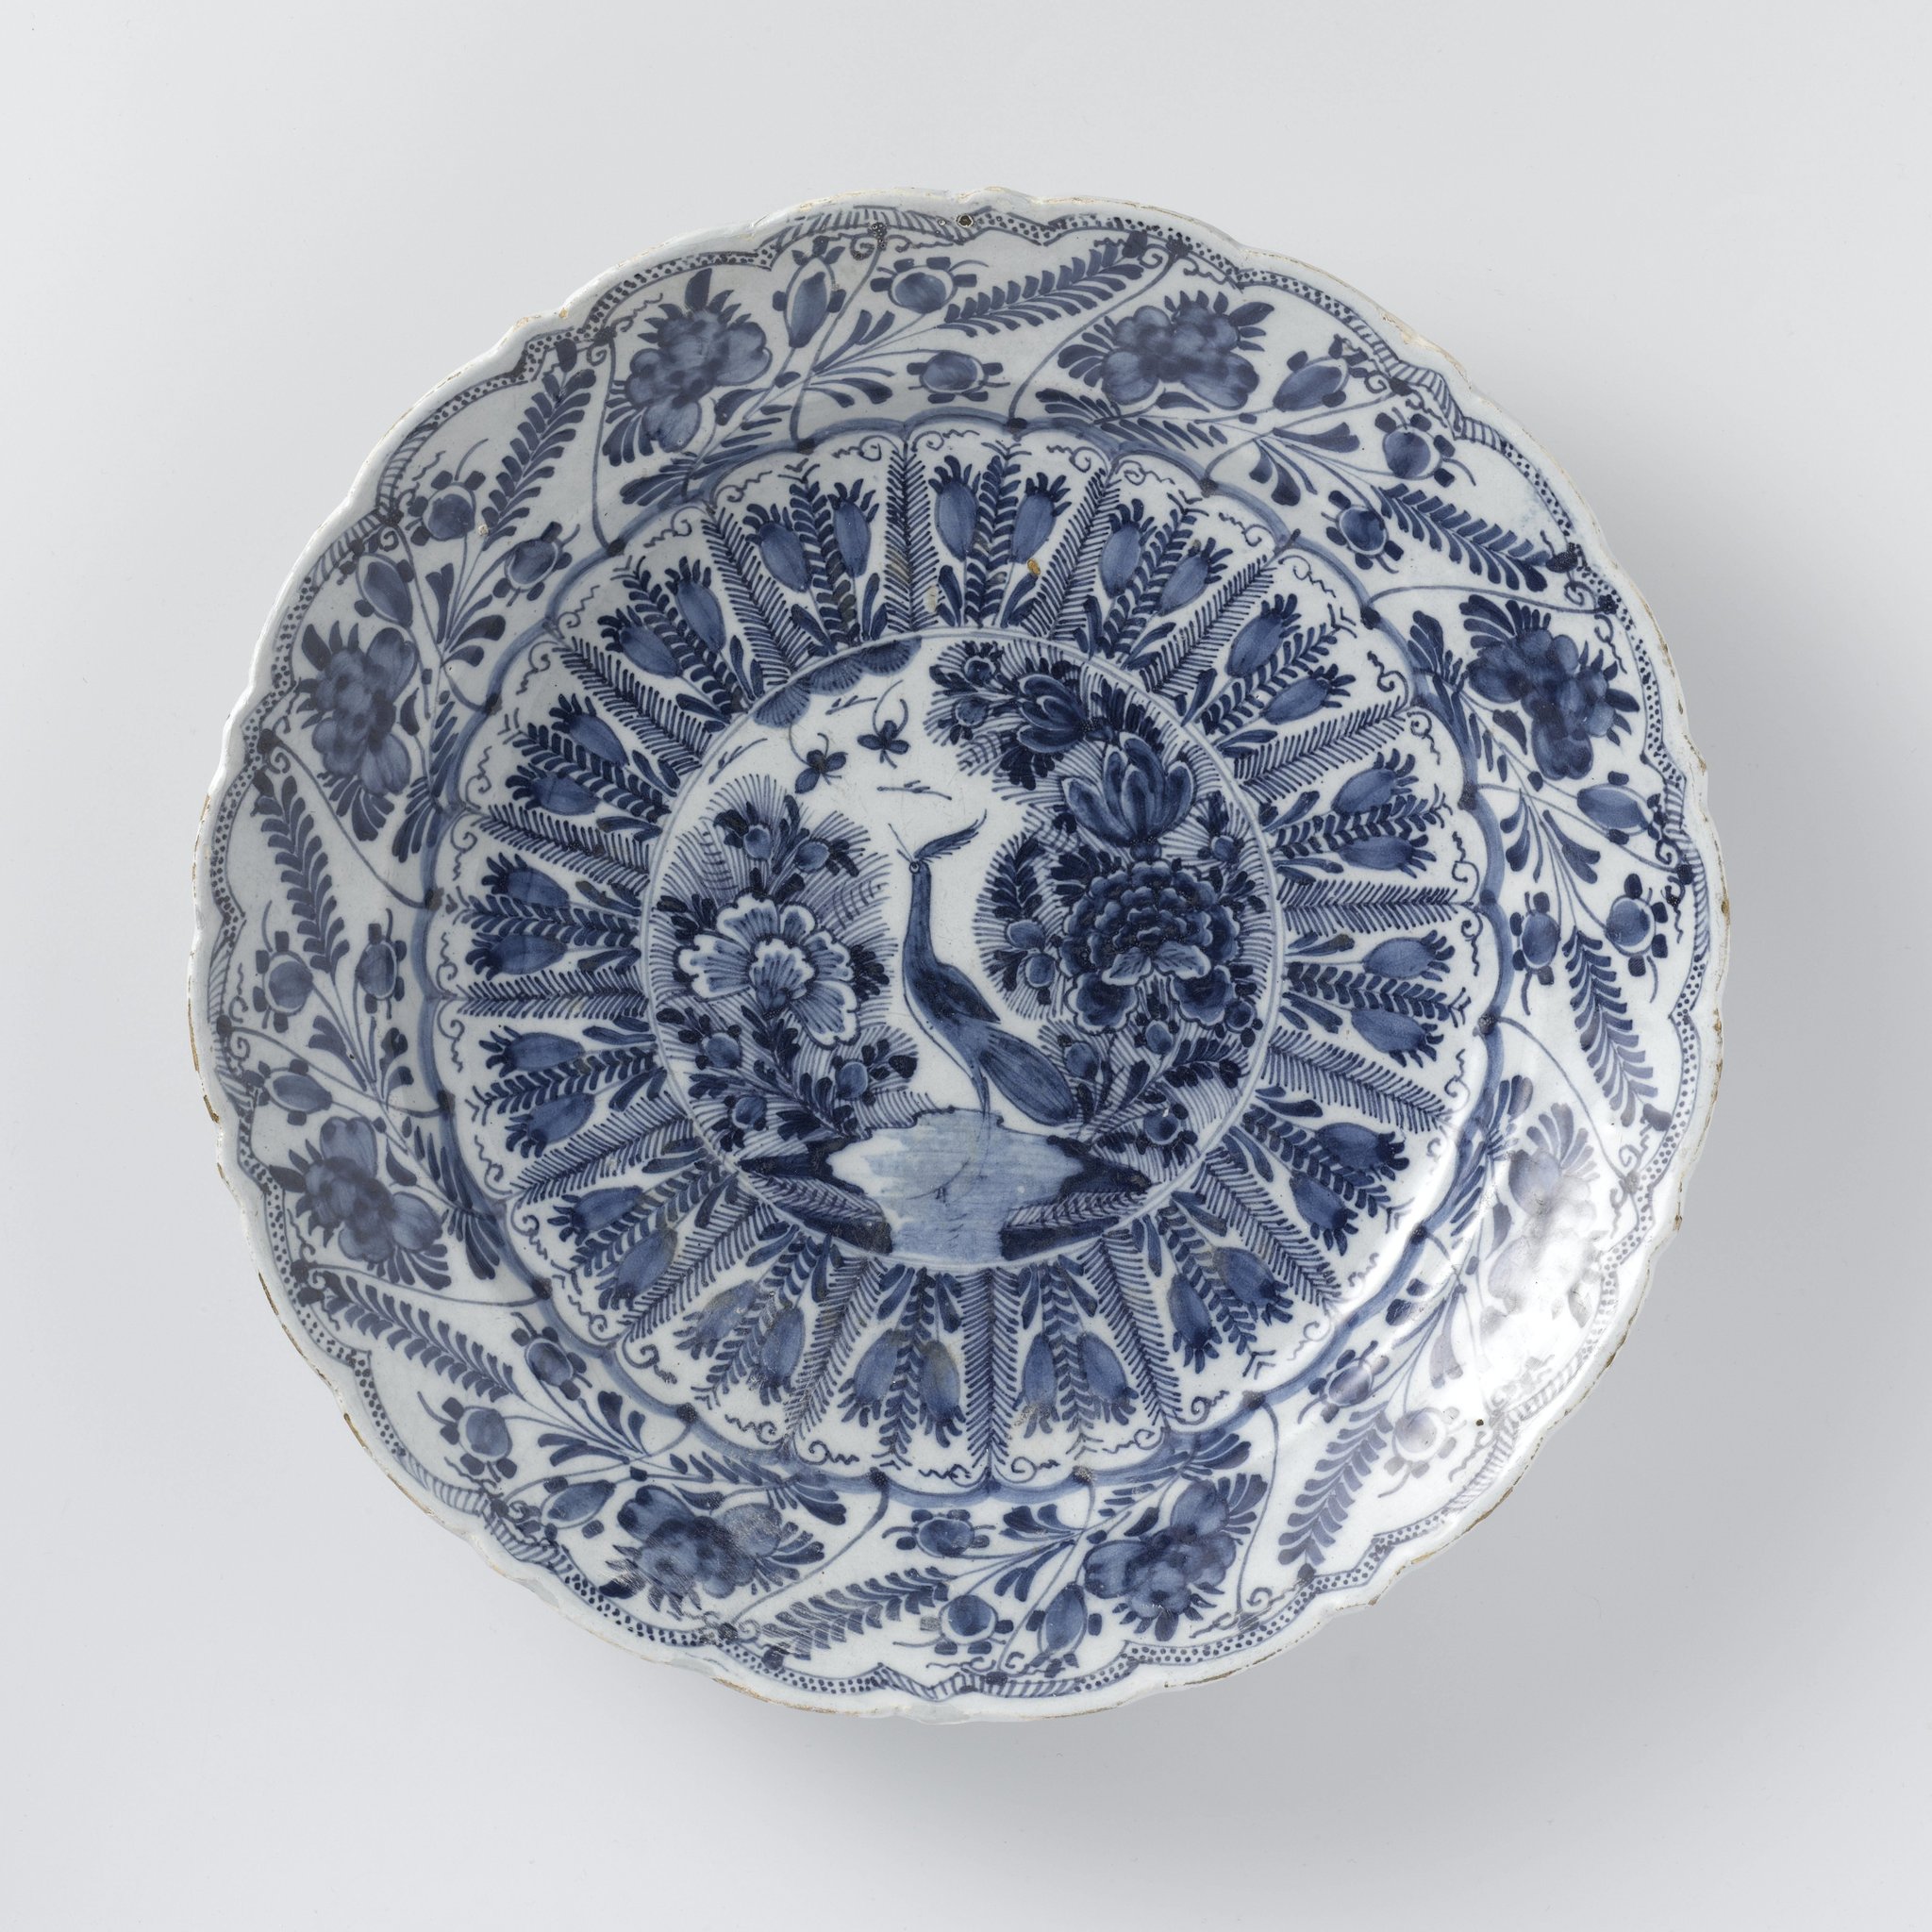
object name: platter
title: Schotel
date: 1740-1790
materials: earthenware, glaze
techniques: painted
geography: delft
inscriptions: mark: ‘L P Kam’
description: Ronde schotel van blauw geschilderde faience, met een geschulpte rand en versierd met het reigerpatroon. De schotel is gemerkt: LP kan Delft Fabr. Bij de schotel horen zes identieke schotels met invnrs. BK-NM-13284-b, BK-NM-13284-c, BK-NM-13284-d, BK-NM-13284-e, BK-NM-13284-f en BK-NM-13284-g.